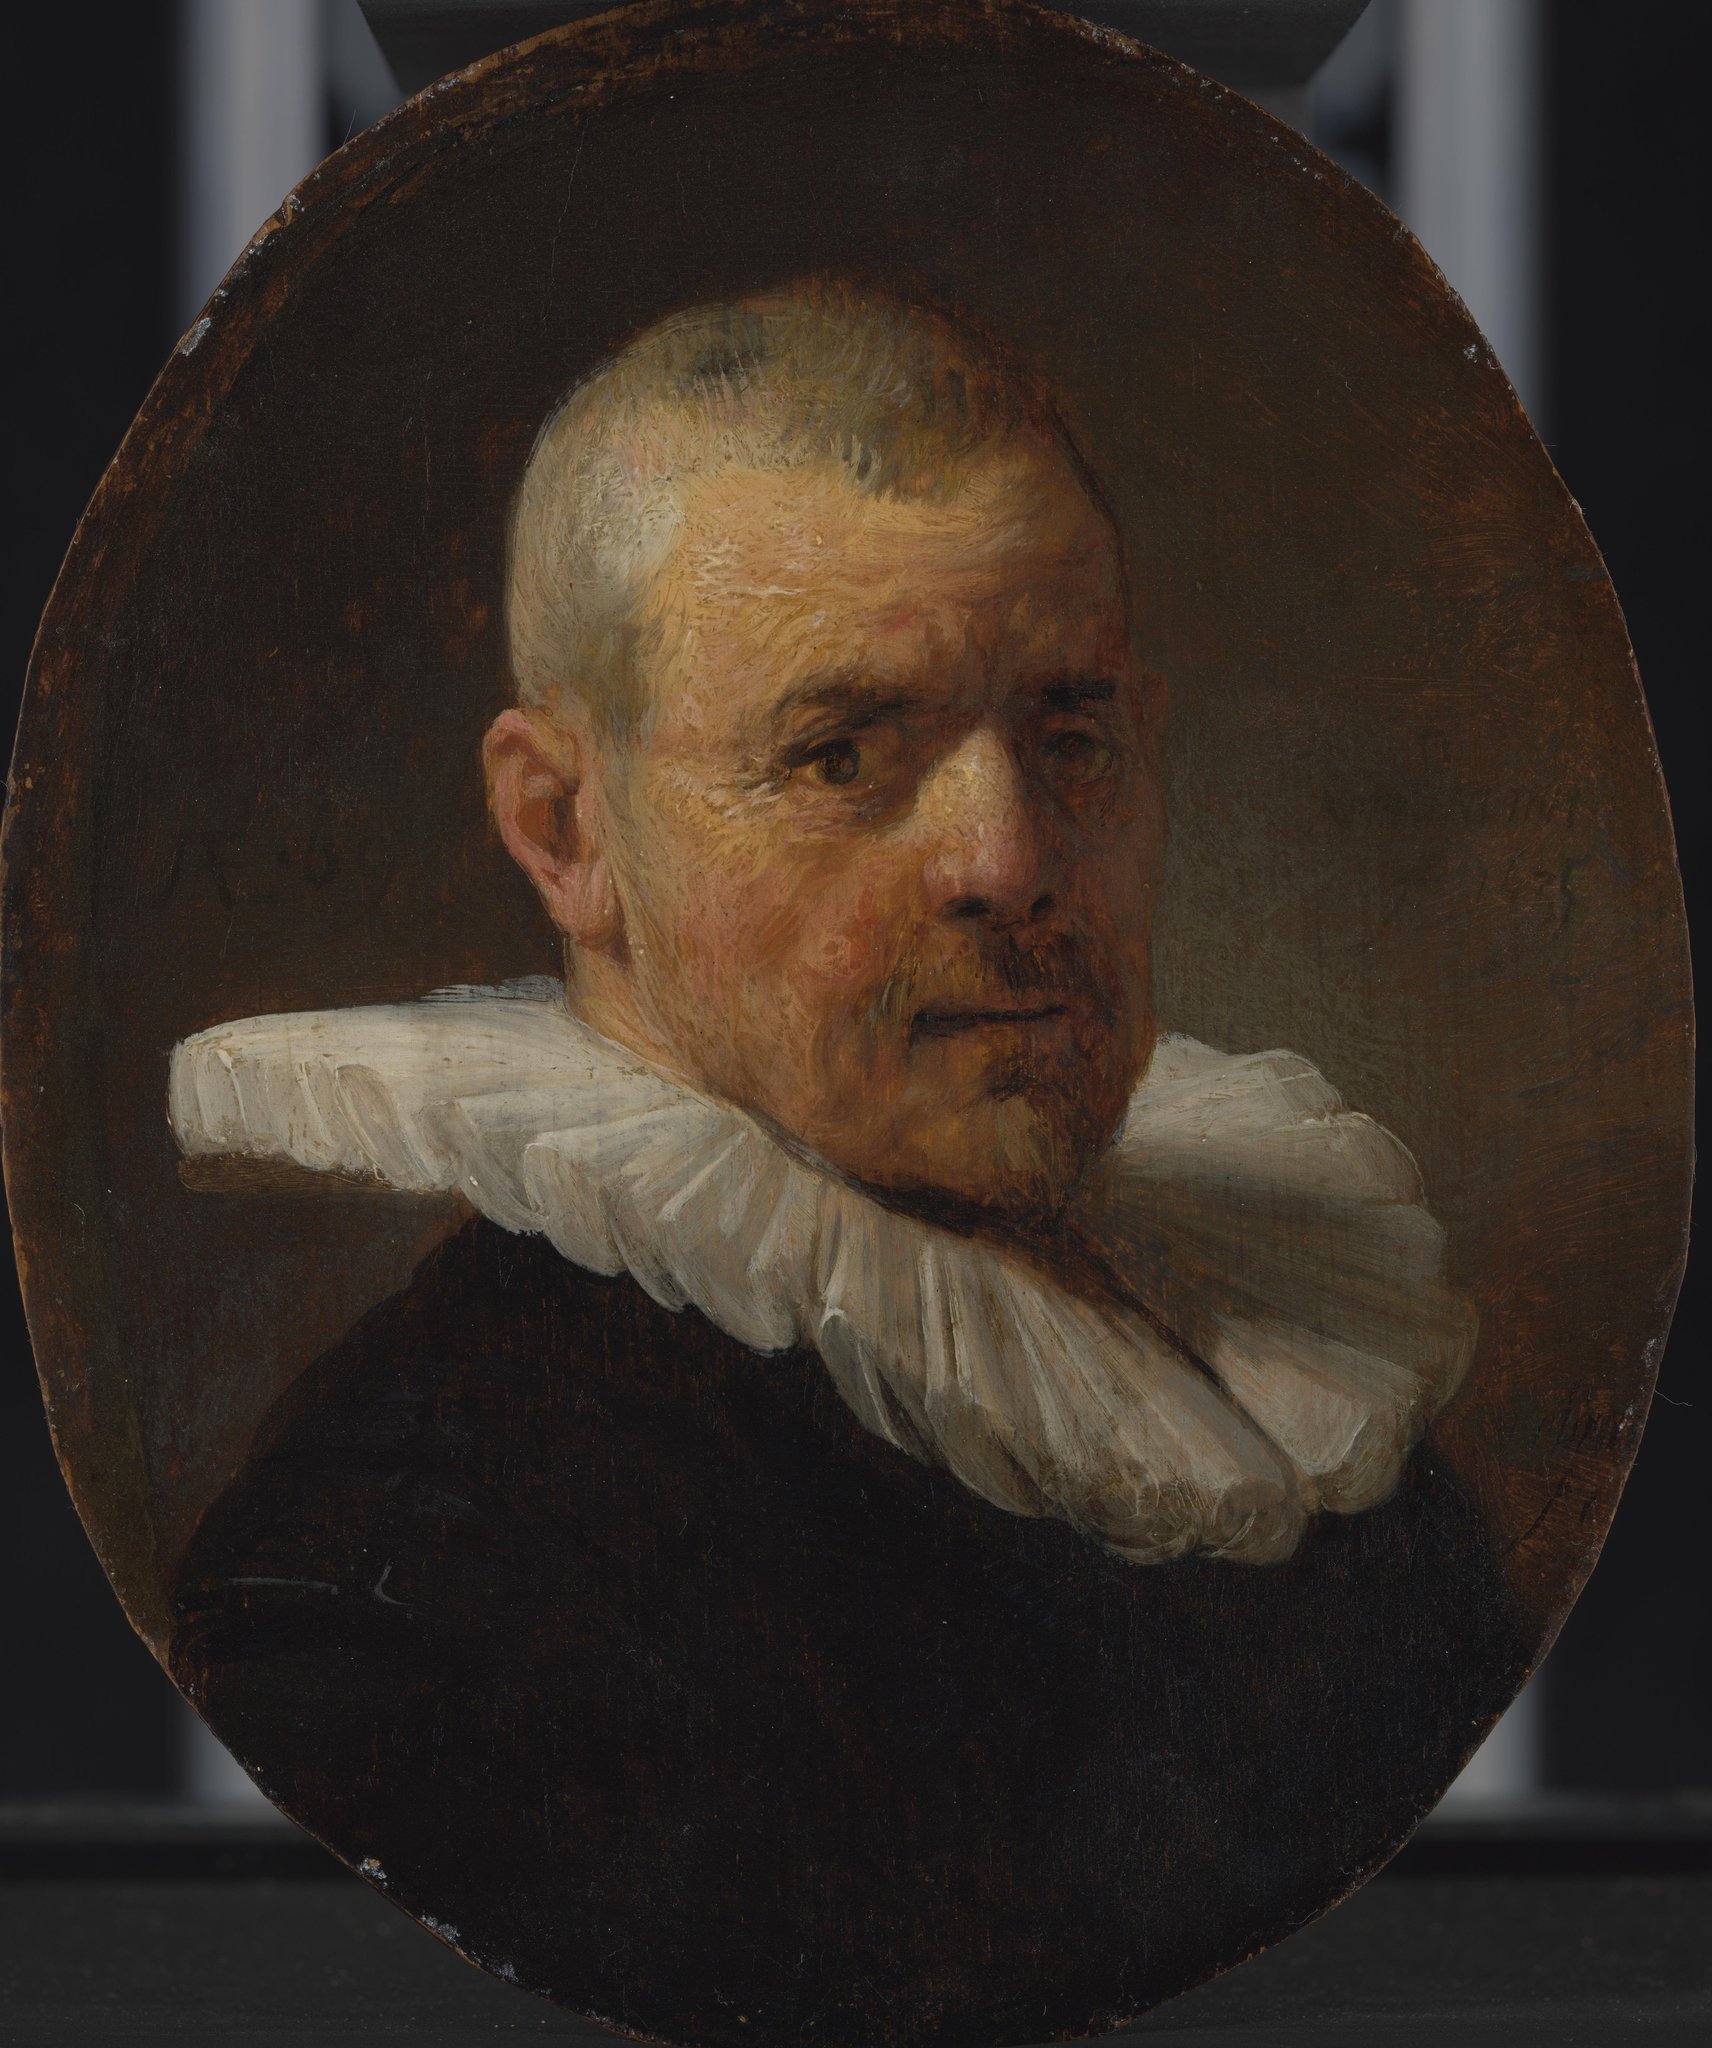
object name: painting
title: Portrait of Jan Willemsz van der Pluym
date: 1635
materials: oil, paint, panel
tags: jan willemsz van der pluym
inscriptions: signature: ‘Remb[...]’, inscription: ‘Æ 69’, signature and date: ‘Rembrandt / f. 1635’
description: Like his forefathers, Jan van der Pluym, here aged 69, was a prosperous slater and plumber in Leiden. Upon his death, he left behind 15 residential houses and to each of his four children 16,000 guilders. These portraits are the smallest Rembrandt ever painted. In contrast to his more formal commissions from strangers, the execution of these family likenesses is very free and sketchy. The artist may have made them as a personal favour.